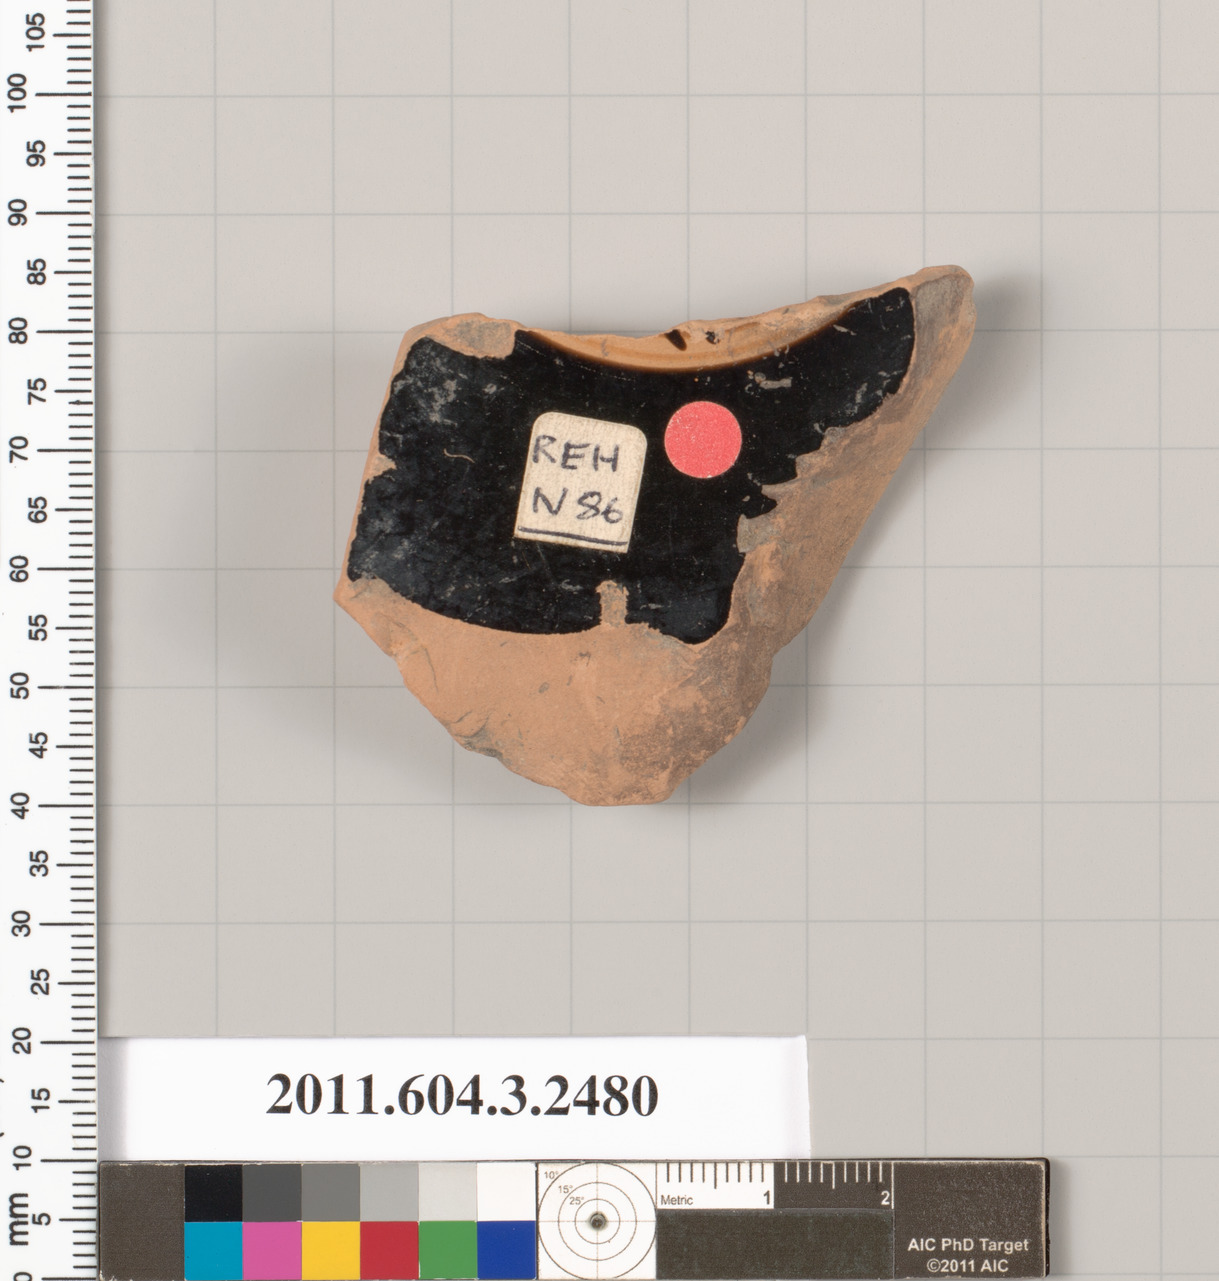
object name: kylix fragment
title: Terracotta fragment of a kylix (drinking cup)?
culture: greek, attic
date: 600-401 BCE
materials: terracotta